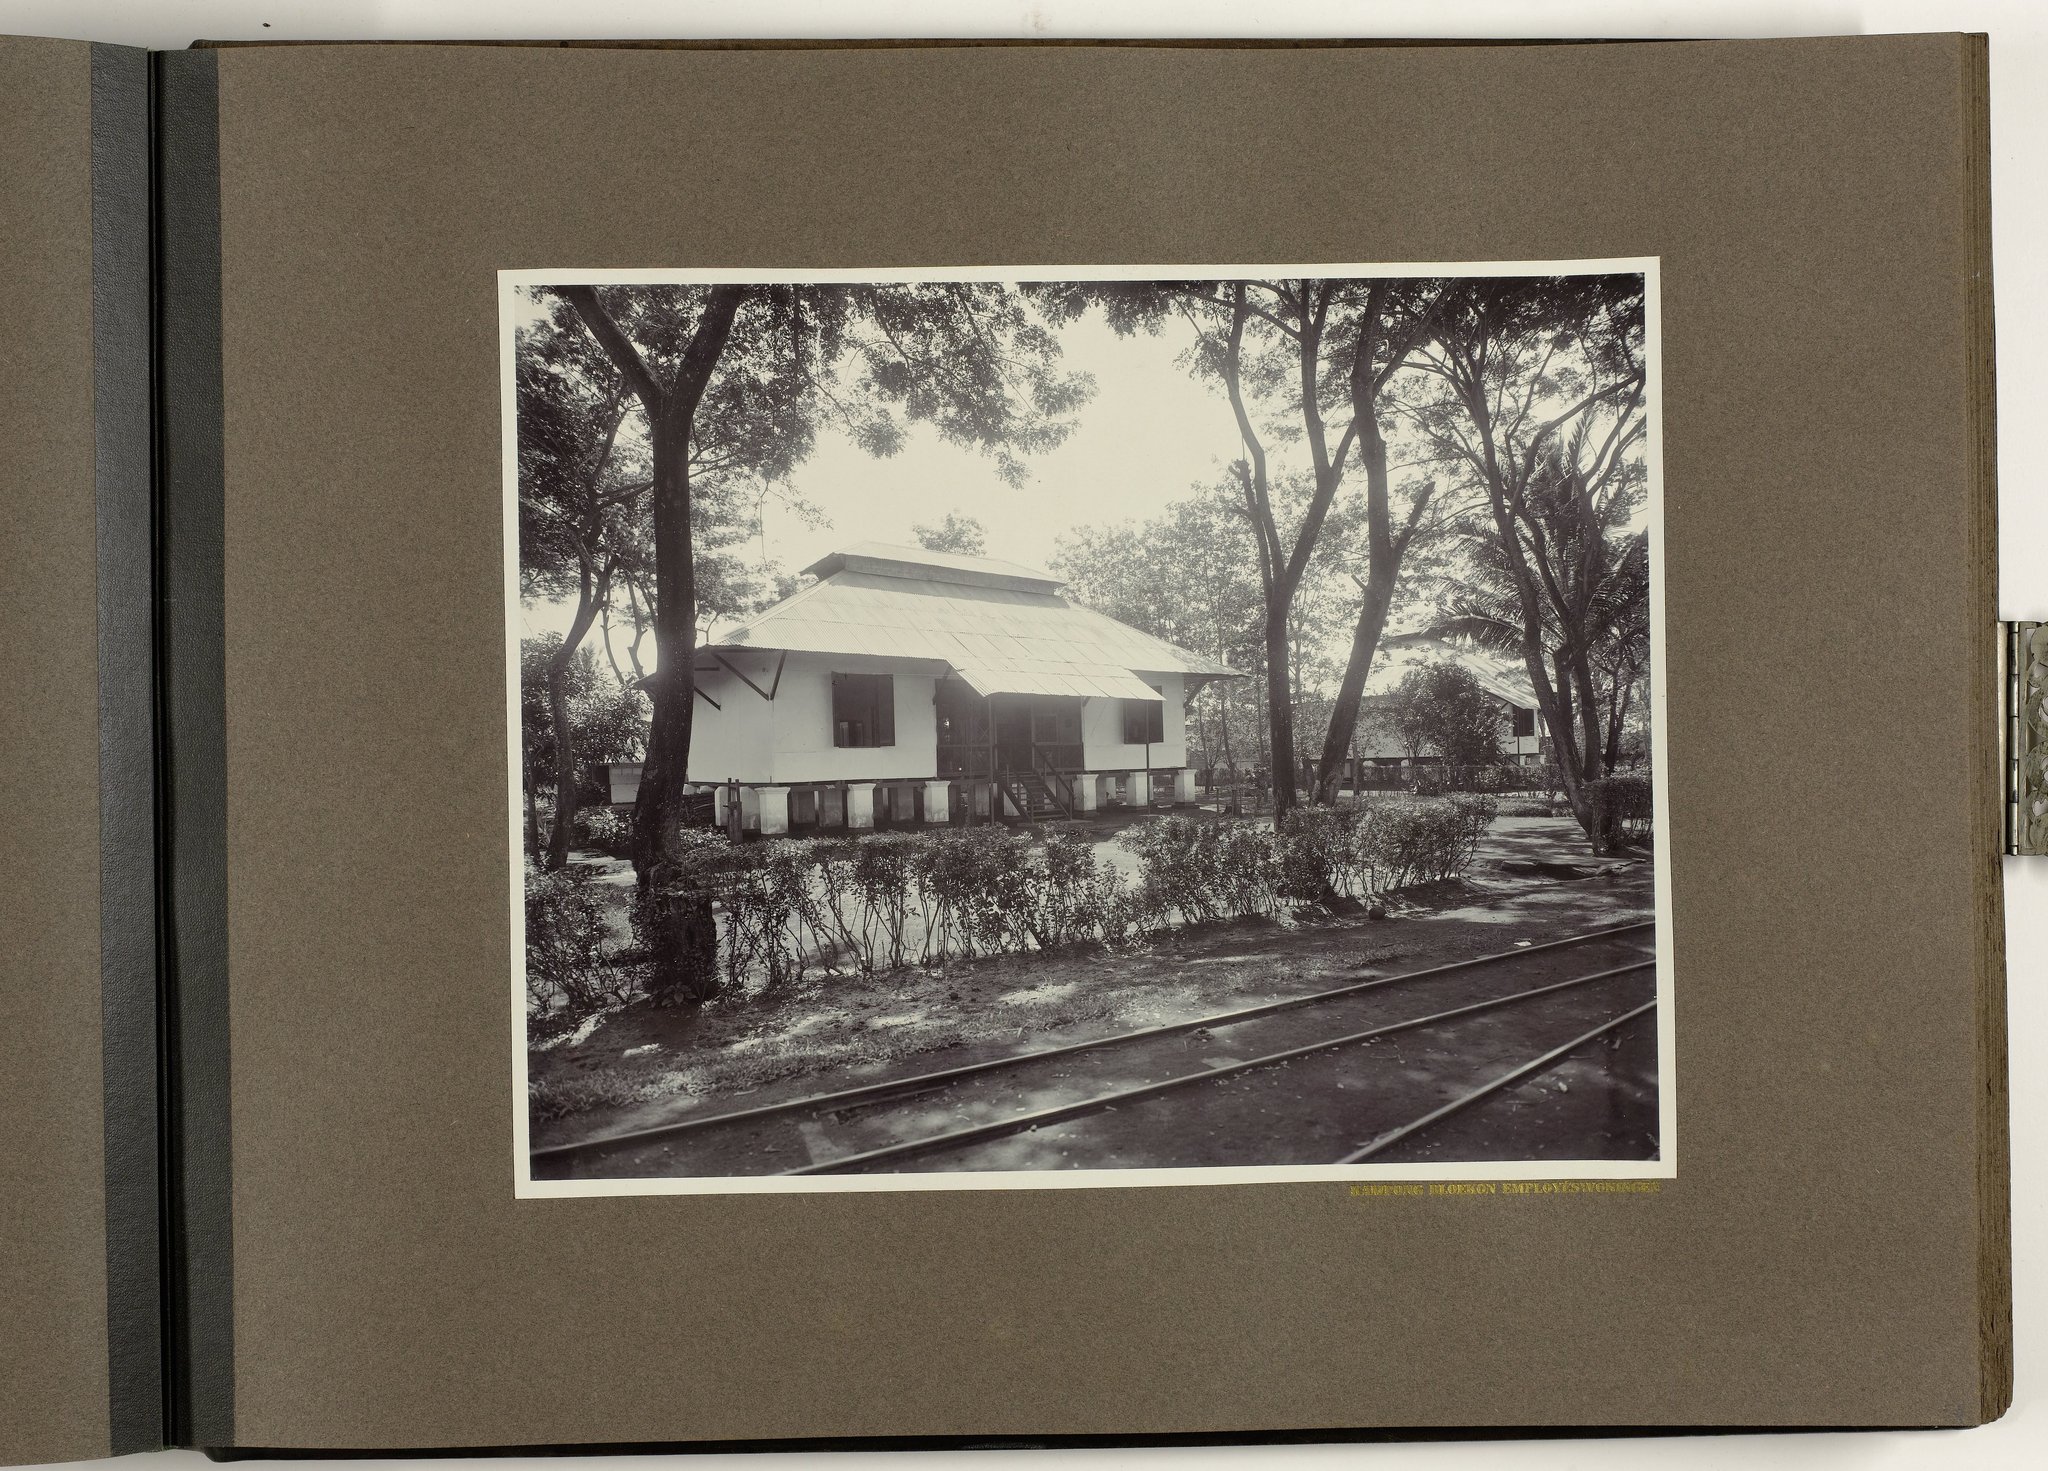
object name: photograph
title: Kampong Bloekon employéswoningen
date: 1917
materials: photographic support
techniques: gelatin silver print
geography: jatiroto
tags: colonial system, (non-fruit) products of plants or trees: sugarcane, rural housing, e.g. country-house, villa, cottage, public road in village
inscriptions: inscription: ‘KAMPONG BLOEKON EMPLOYÉSWONINGEN’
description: Werknemerswoningen in het dorp Bloekon. Witte huizen op palen, voor de huizen lopen rails. Onderdeel van het fotoalbum aangeboden aan F.J. Wirix door het personeel van de Suikeronderneming Djatiroto in 1917.